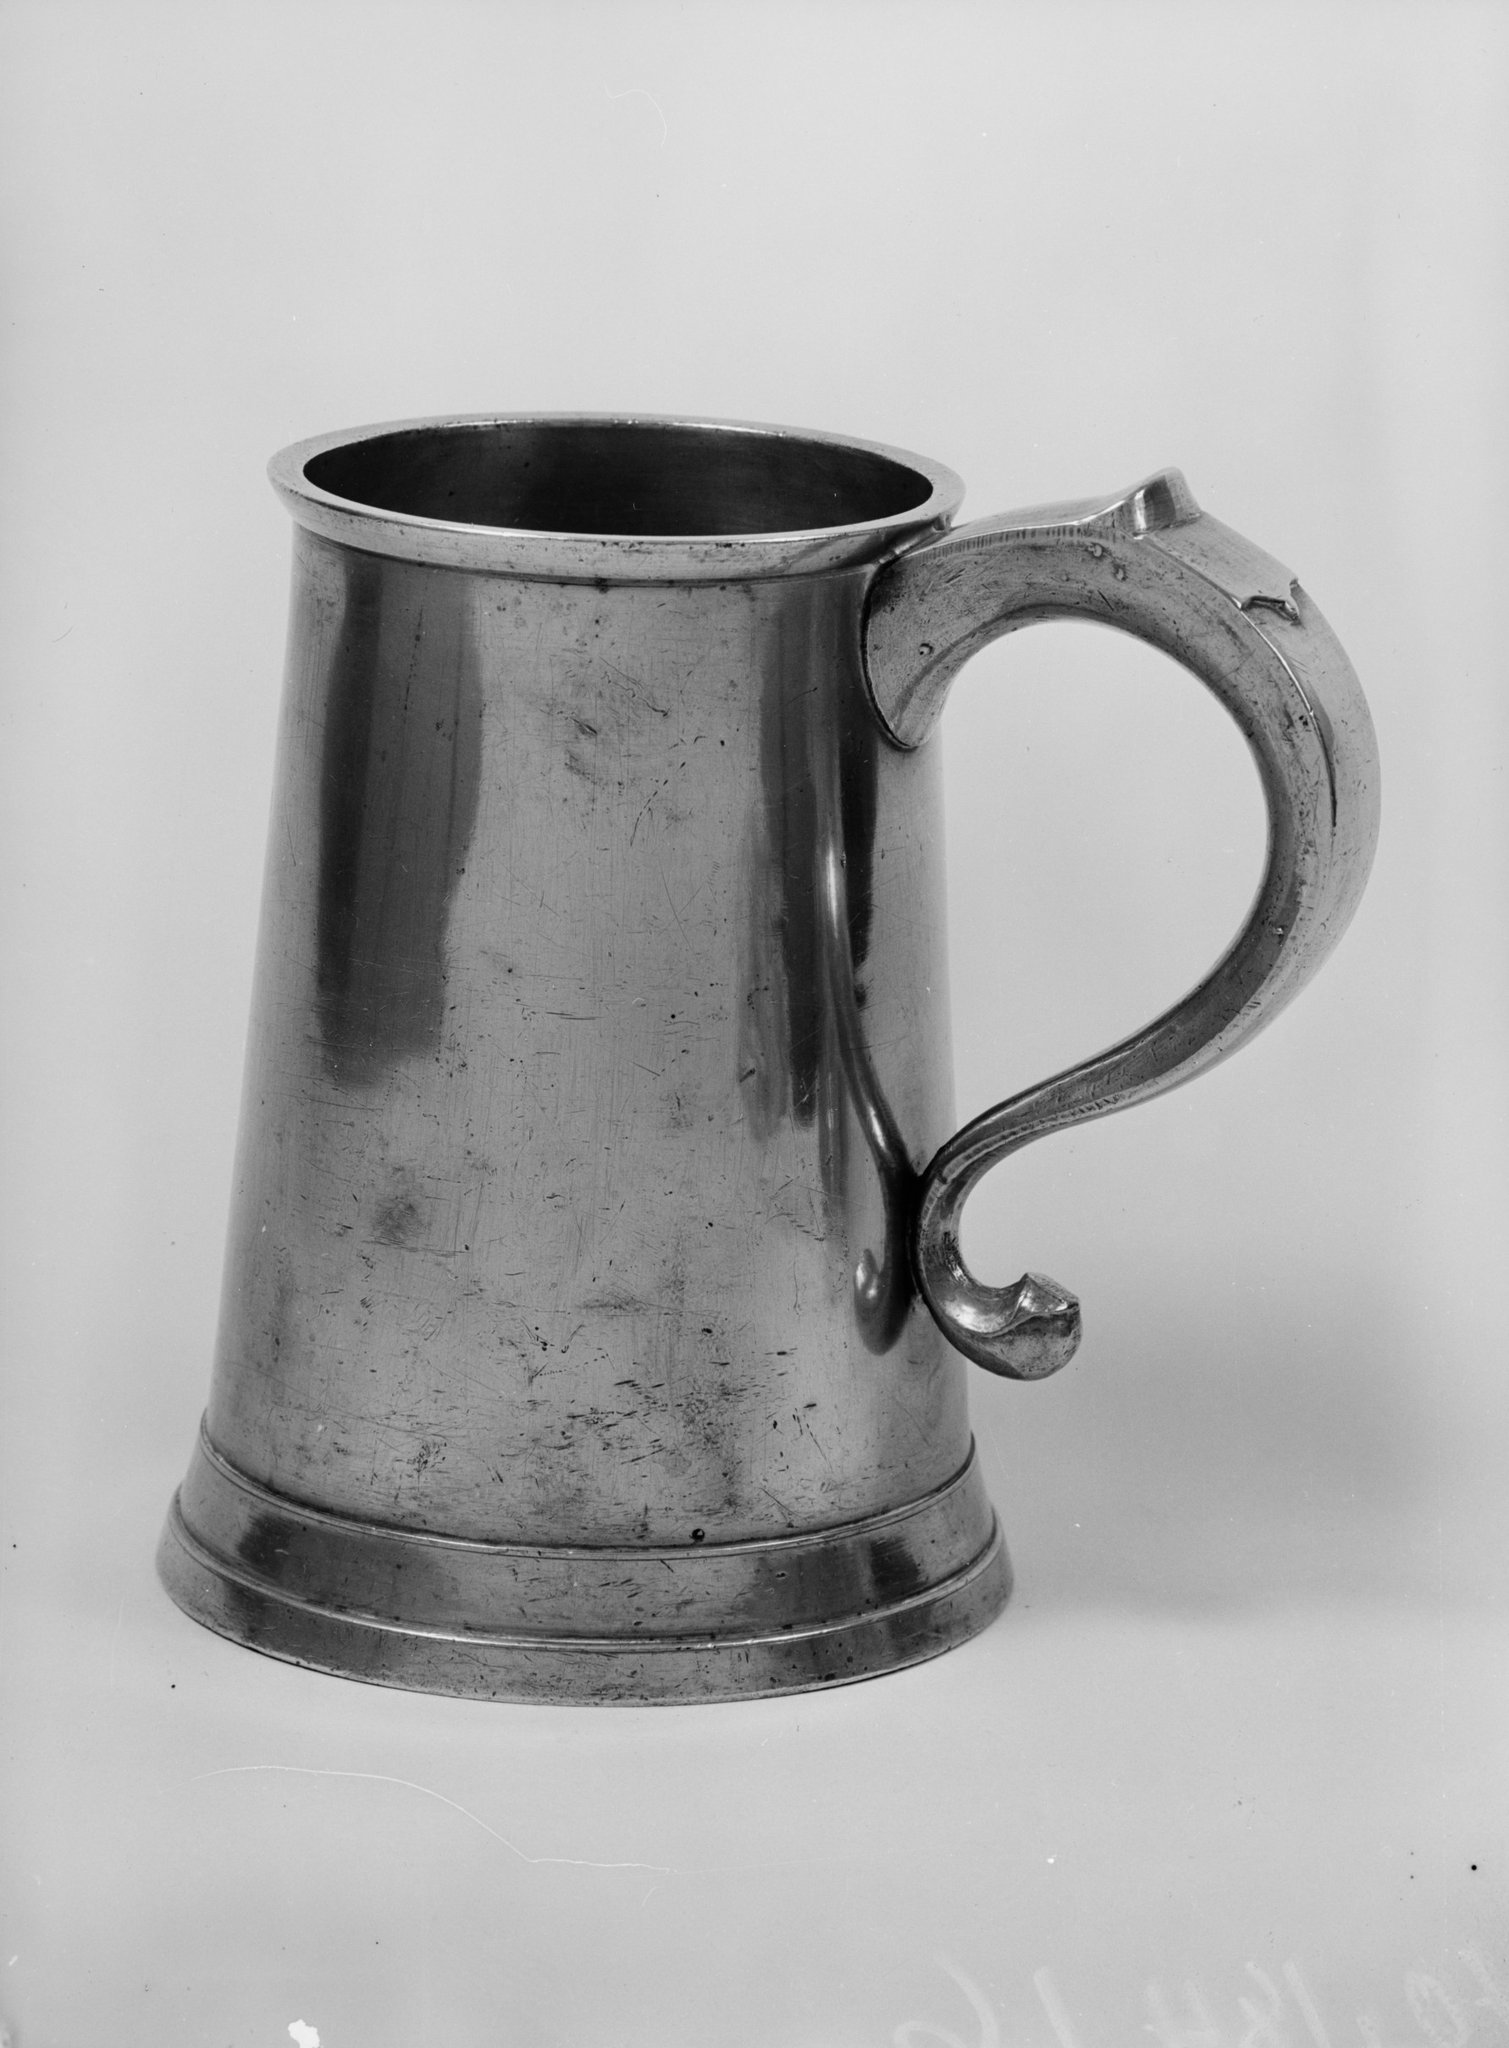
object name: mug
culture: american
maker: henry will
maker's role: maker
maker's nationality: american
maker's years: 1734-1802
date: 1761-1793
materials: pewter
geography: united states